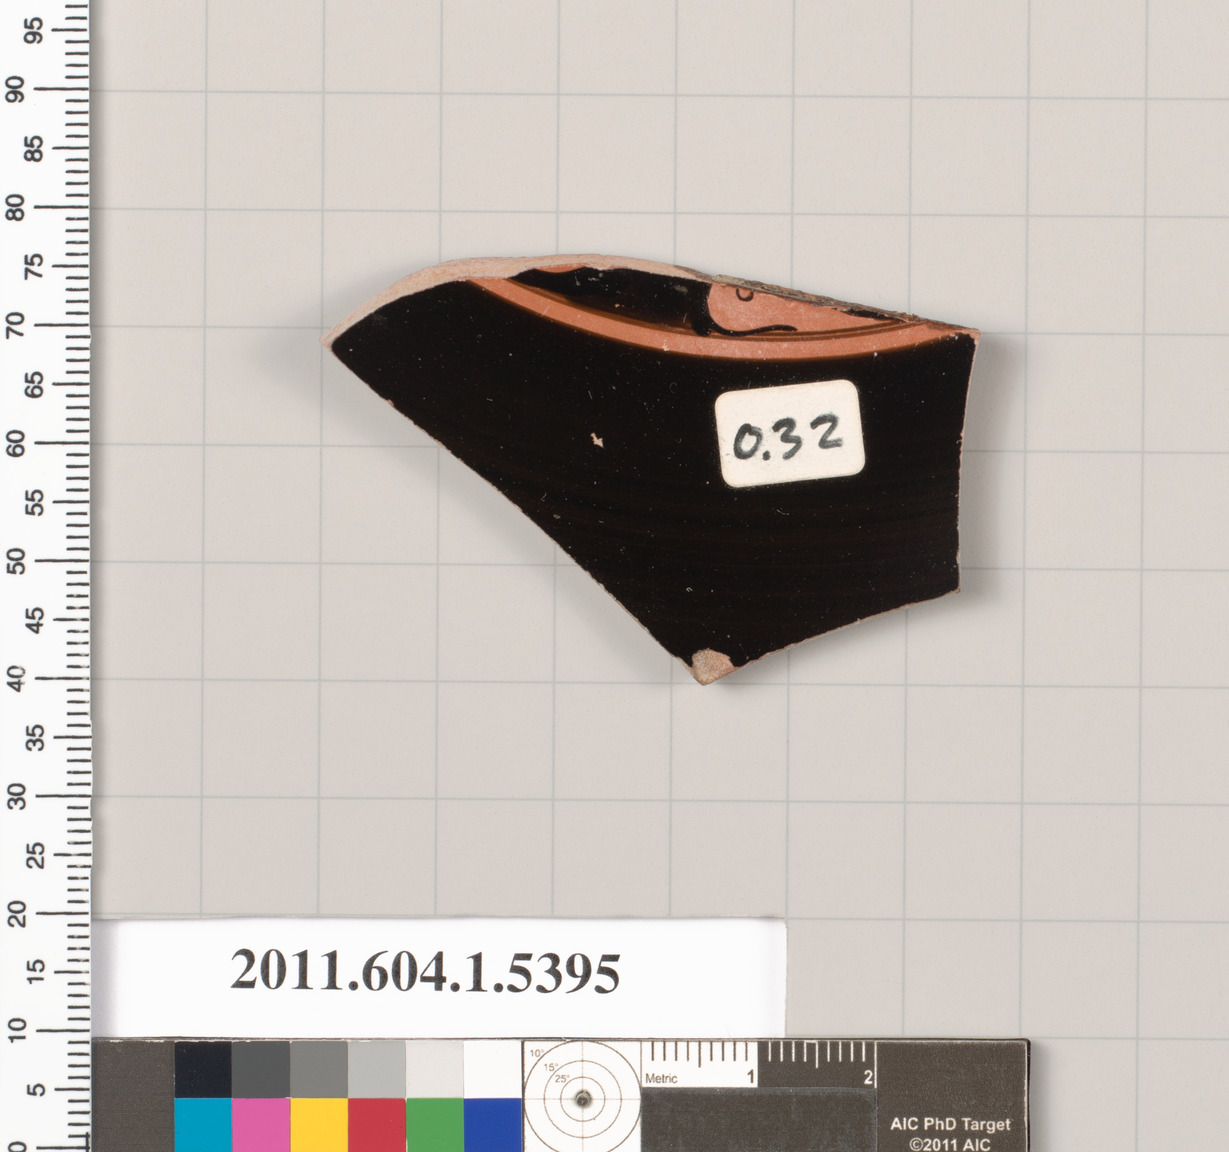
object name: kylix fragment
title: Terracotta fragment of a kylix (drinking cup)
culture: greek, attic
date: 510-490 BCE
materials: terracotta